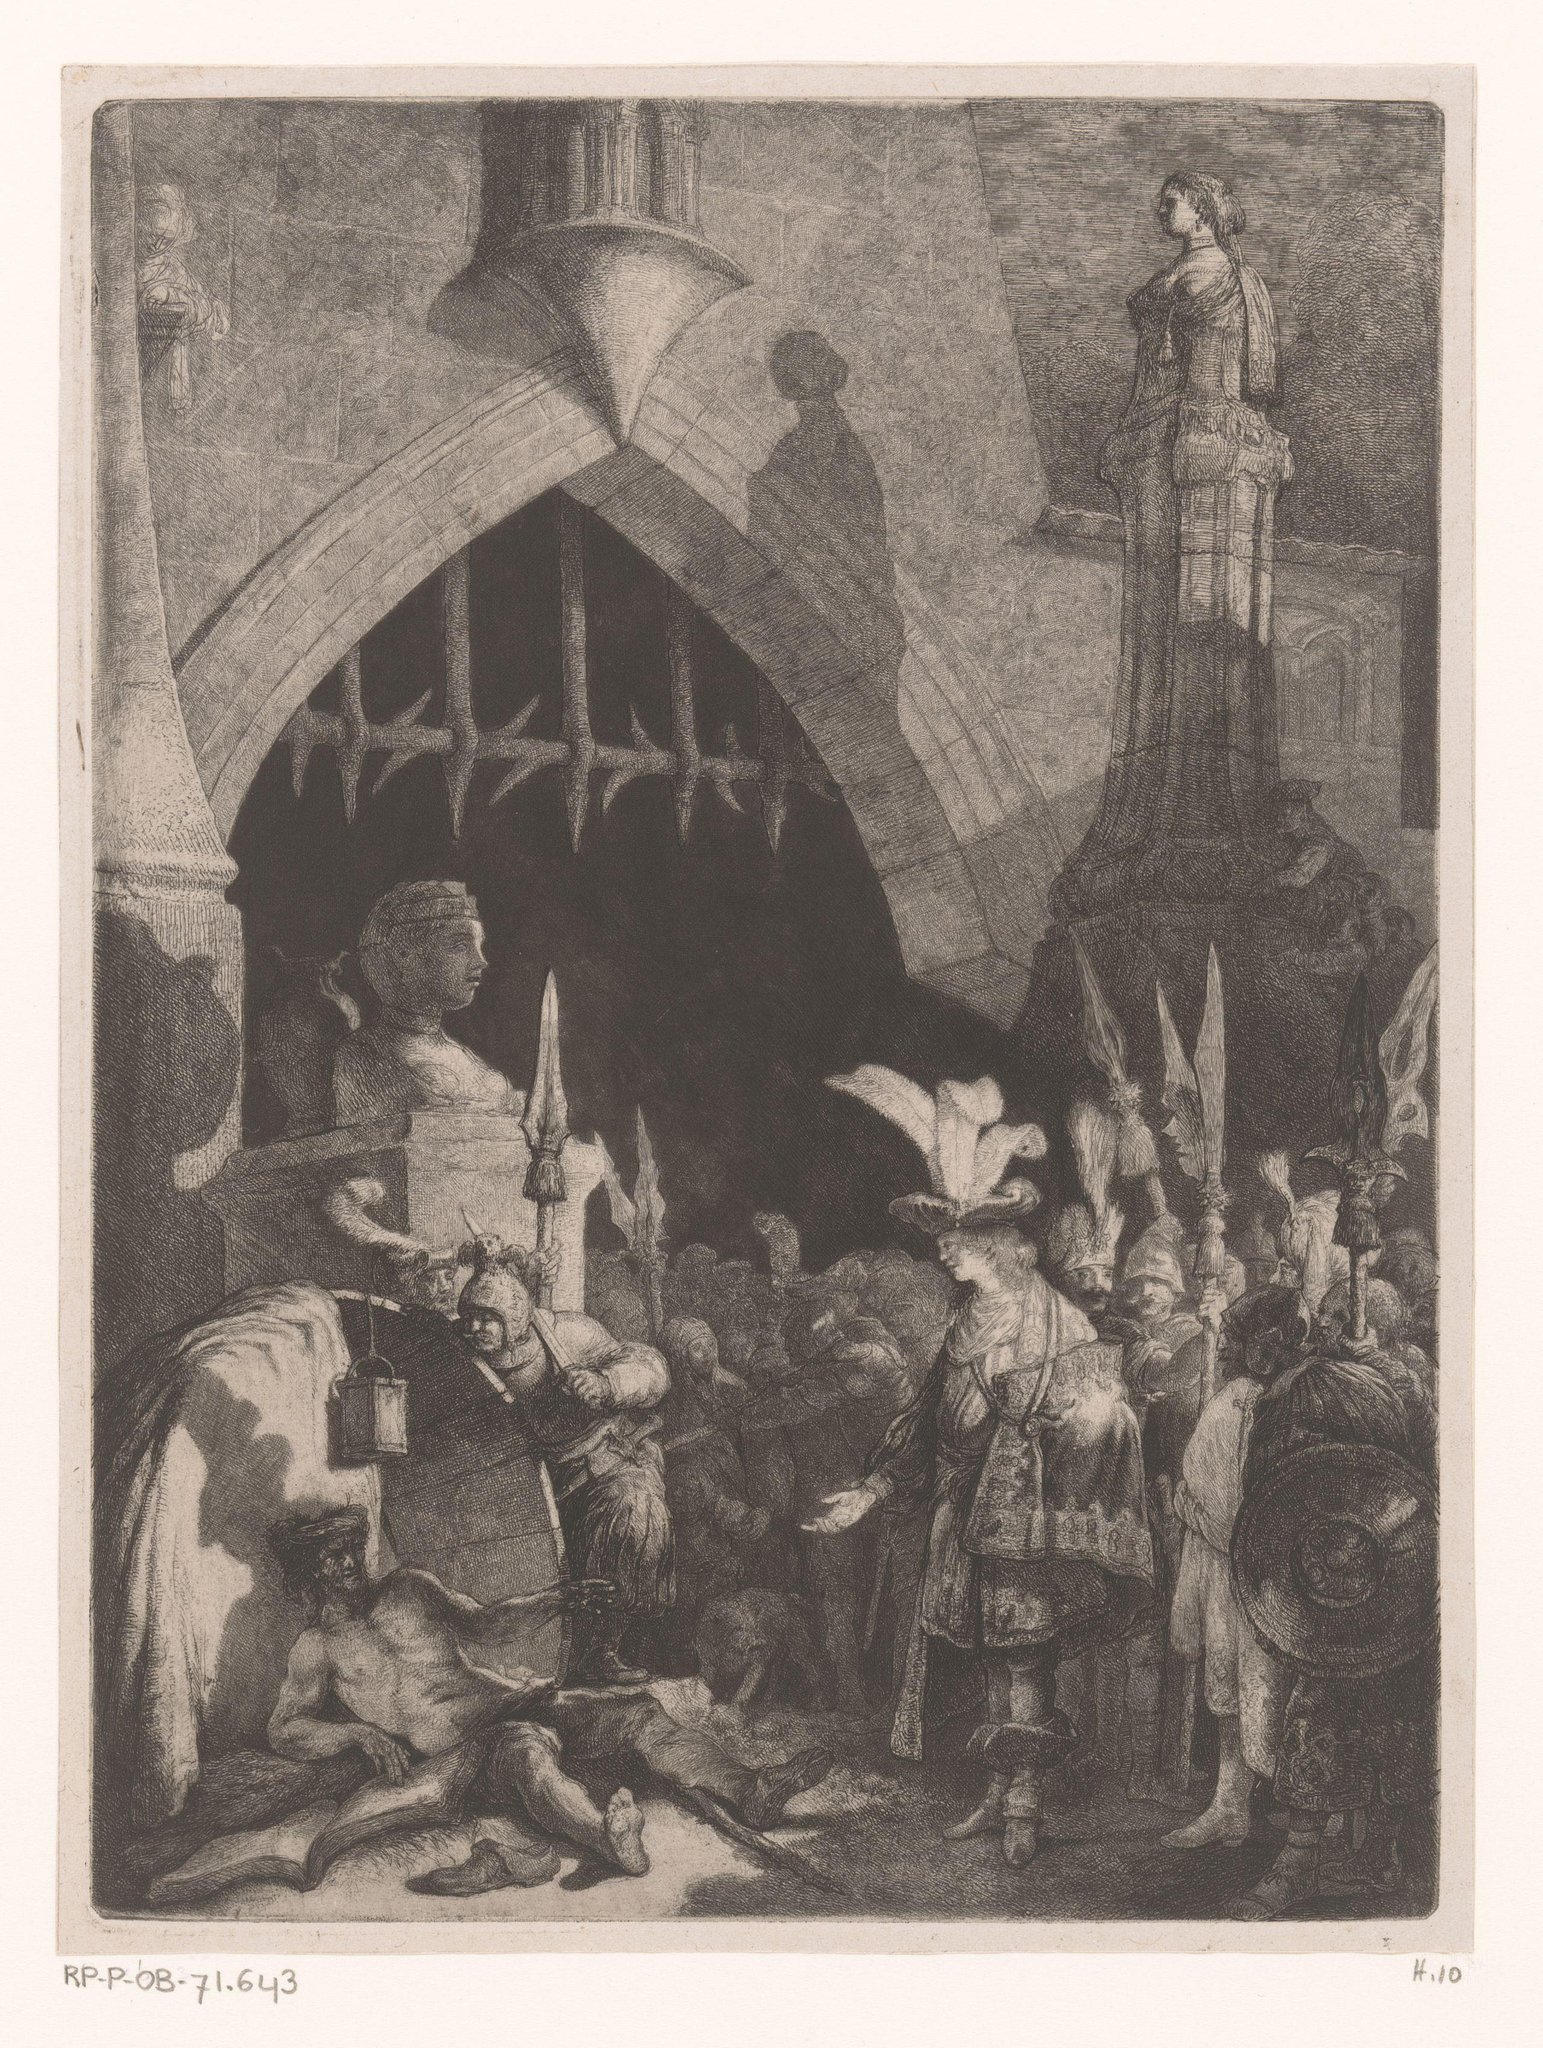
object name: print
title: Diogenes en Alexander de Grote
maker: jean pierre norblin de la gourdaine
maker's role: print maker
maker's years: 1745-1830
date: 1755-1830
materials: paper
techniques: etching, intaglio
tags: historical persons, alexander's visit to diogenes, who sits by his barrel and asks alexander to get out of his light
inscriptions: collector's mark: Lugt 2228